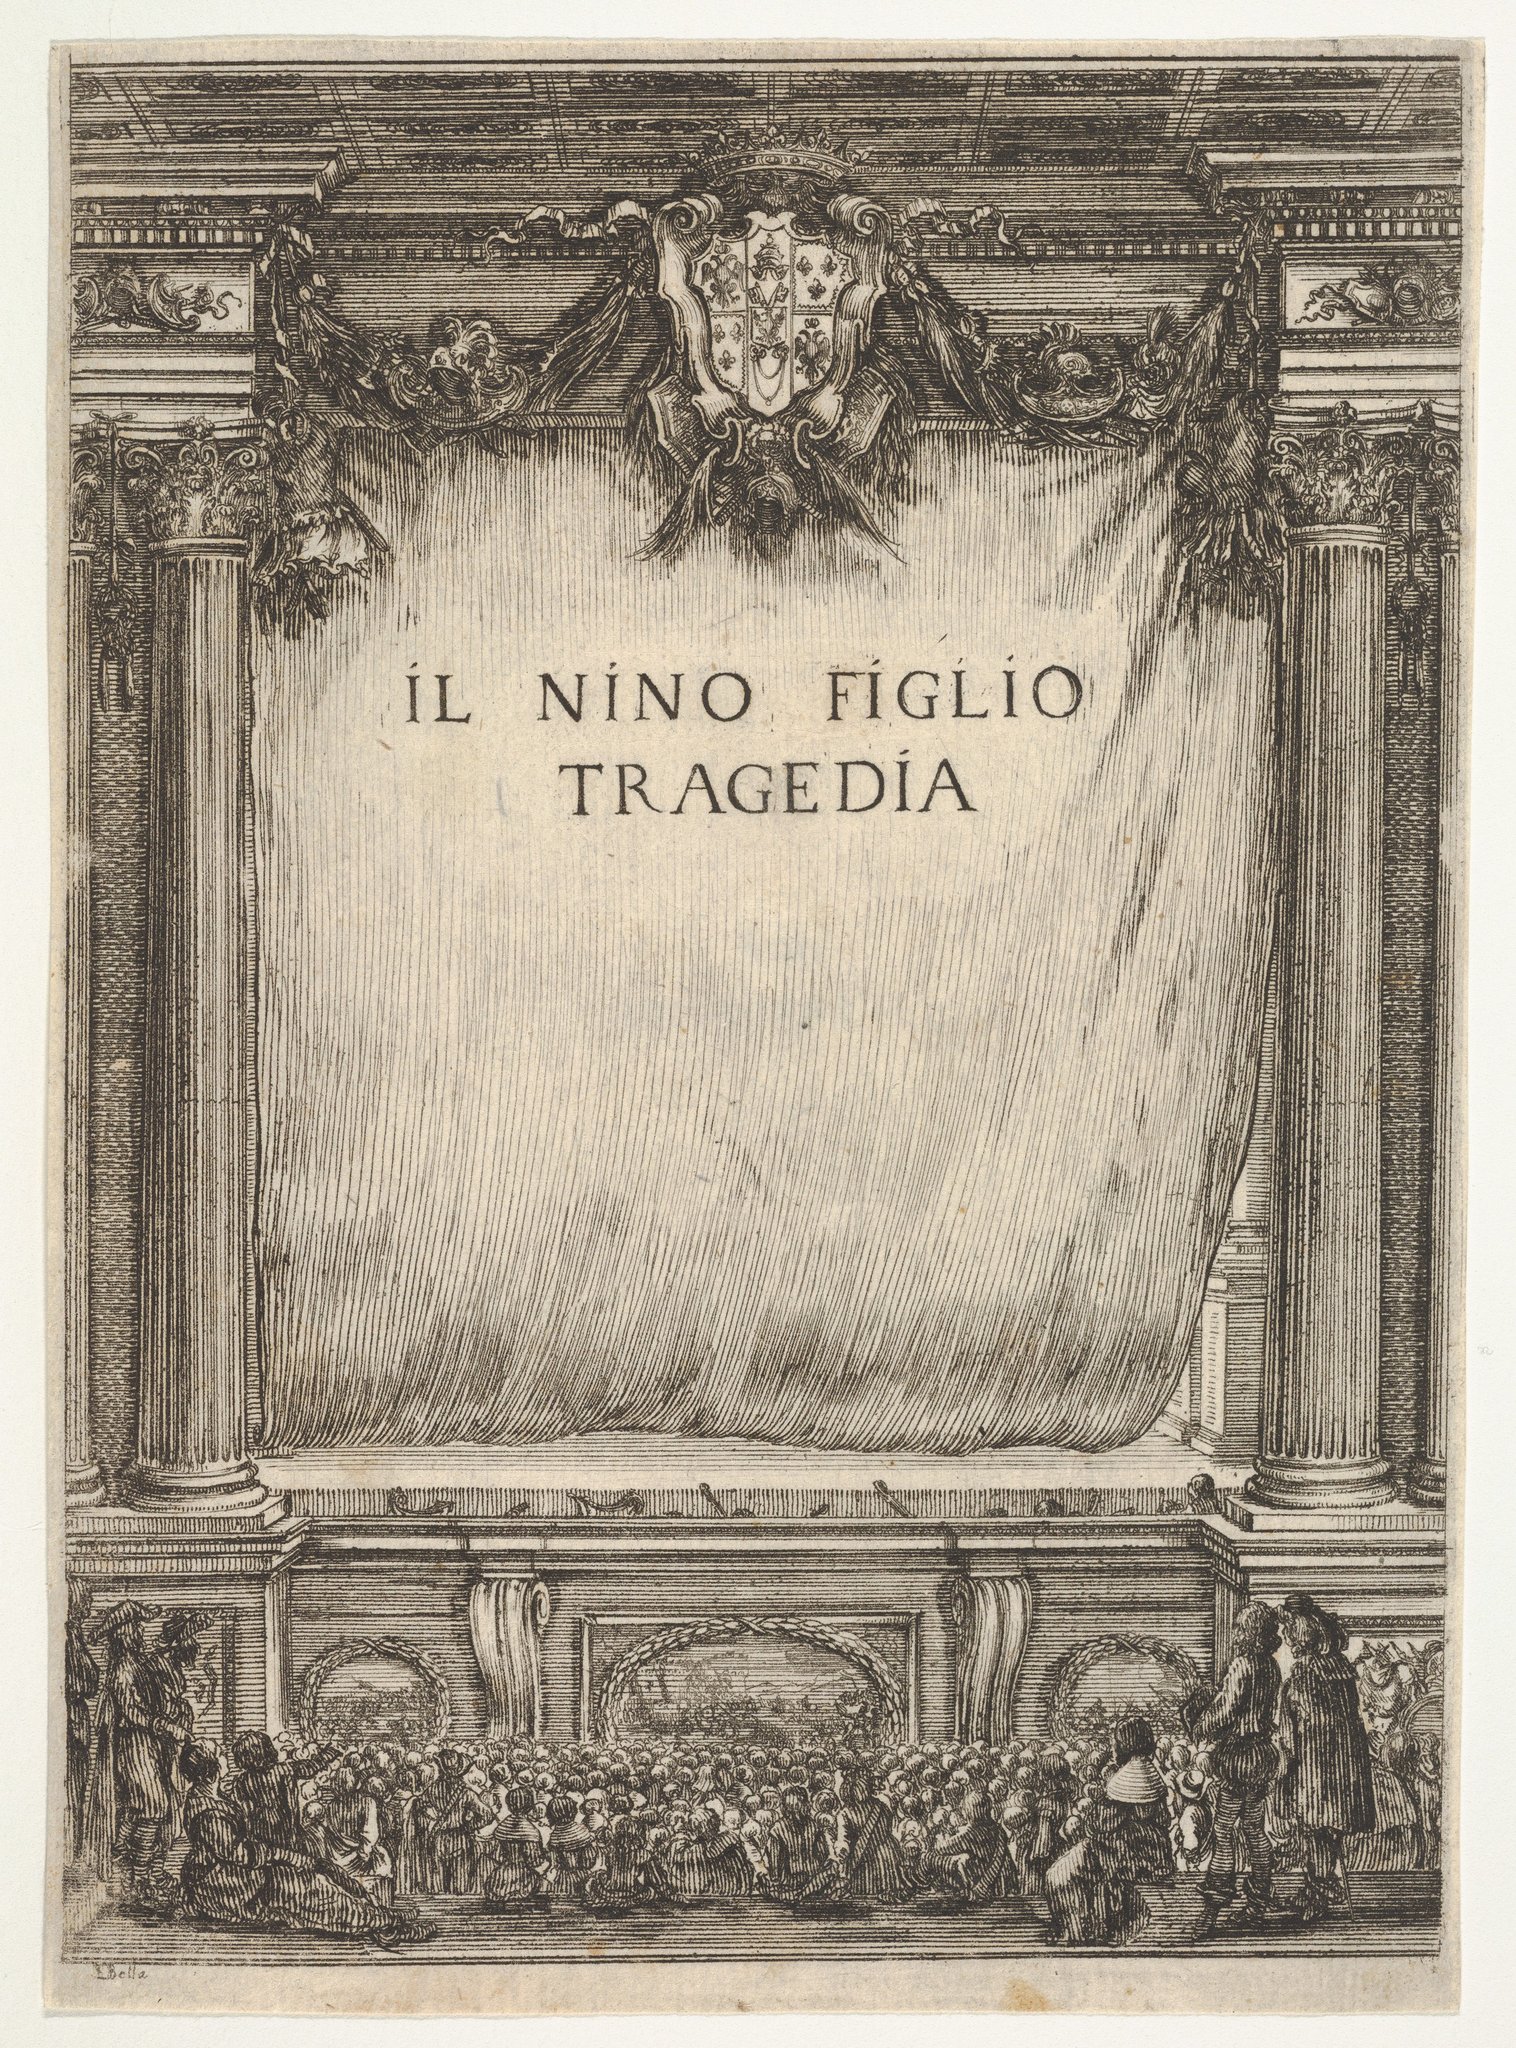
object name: print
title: Title page for "The Child Nino" (Il Nino Figlio), a stage with the curtain drawn, the coat of arms of the duke of Modena at top center, spectators below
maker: stefano della bella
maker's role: artist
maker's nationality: italian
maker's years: 1610-1664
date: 1655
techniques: etching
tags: theatre,spectators,coat of arms